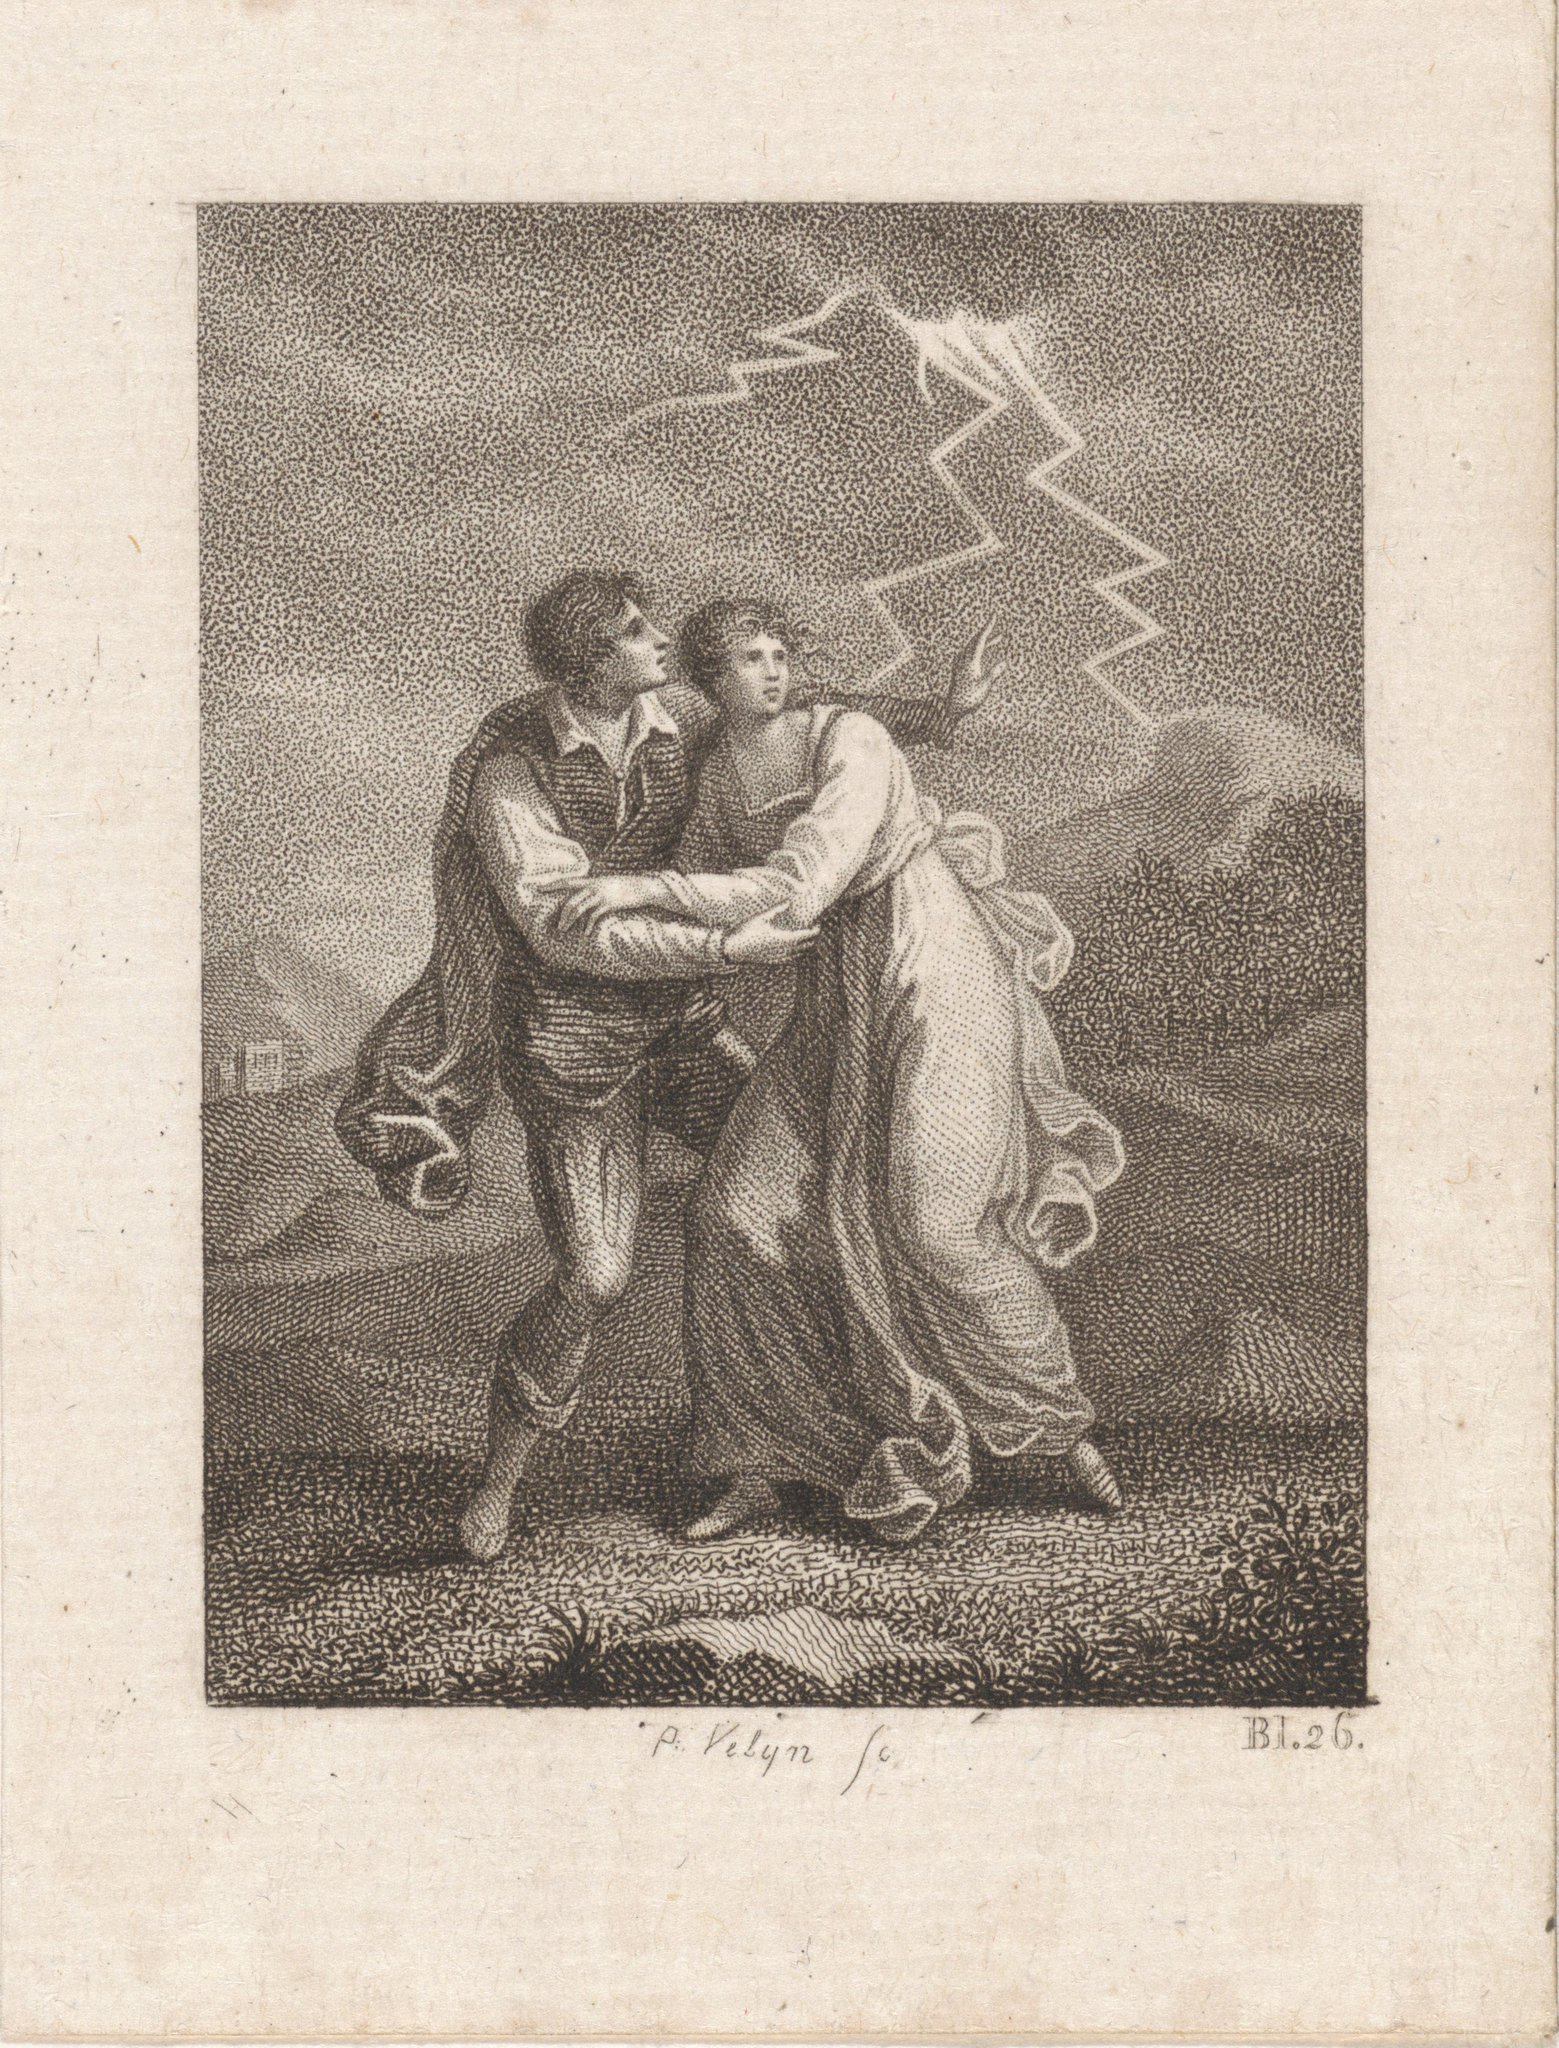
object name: print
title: Paar in een landschap bij bliksem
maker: philippus velijn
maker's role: print maker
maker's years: 1787-1836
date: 1818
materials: paper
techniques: etching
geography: netherlands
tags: youth, adolescent, lightning, flash of lightning, thunderbolt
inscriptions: collector's mark: Lugt 2228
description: Een jong paar klampt zich aan elkaar vast in een landschap bij onweer. In de lucht bliksemschichten. Rechtsonder: bl. 26.